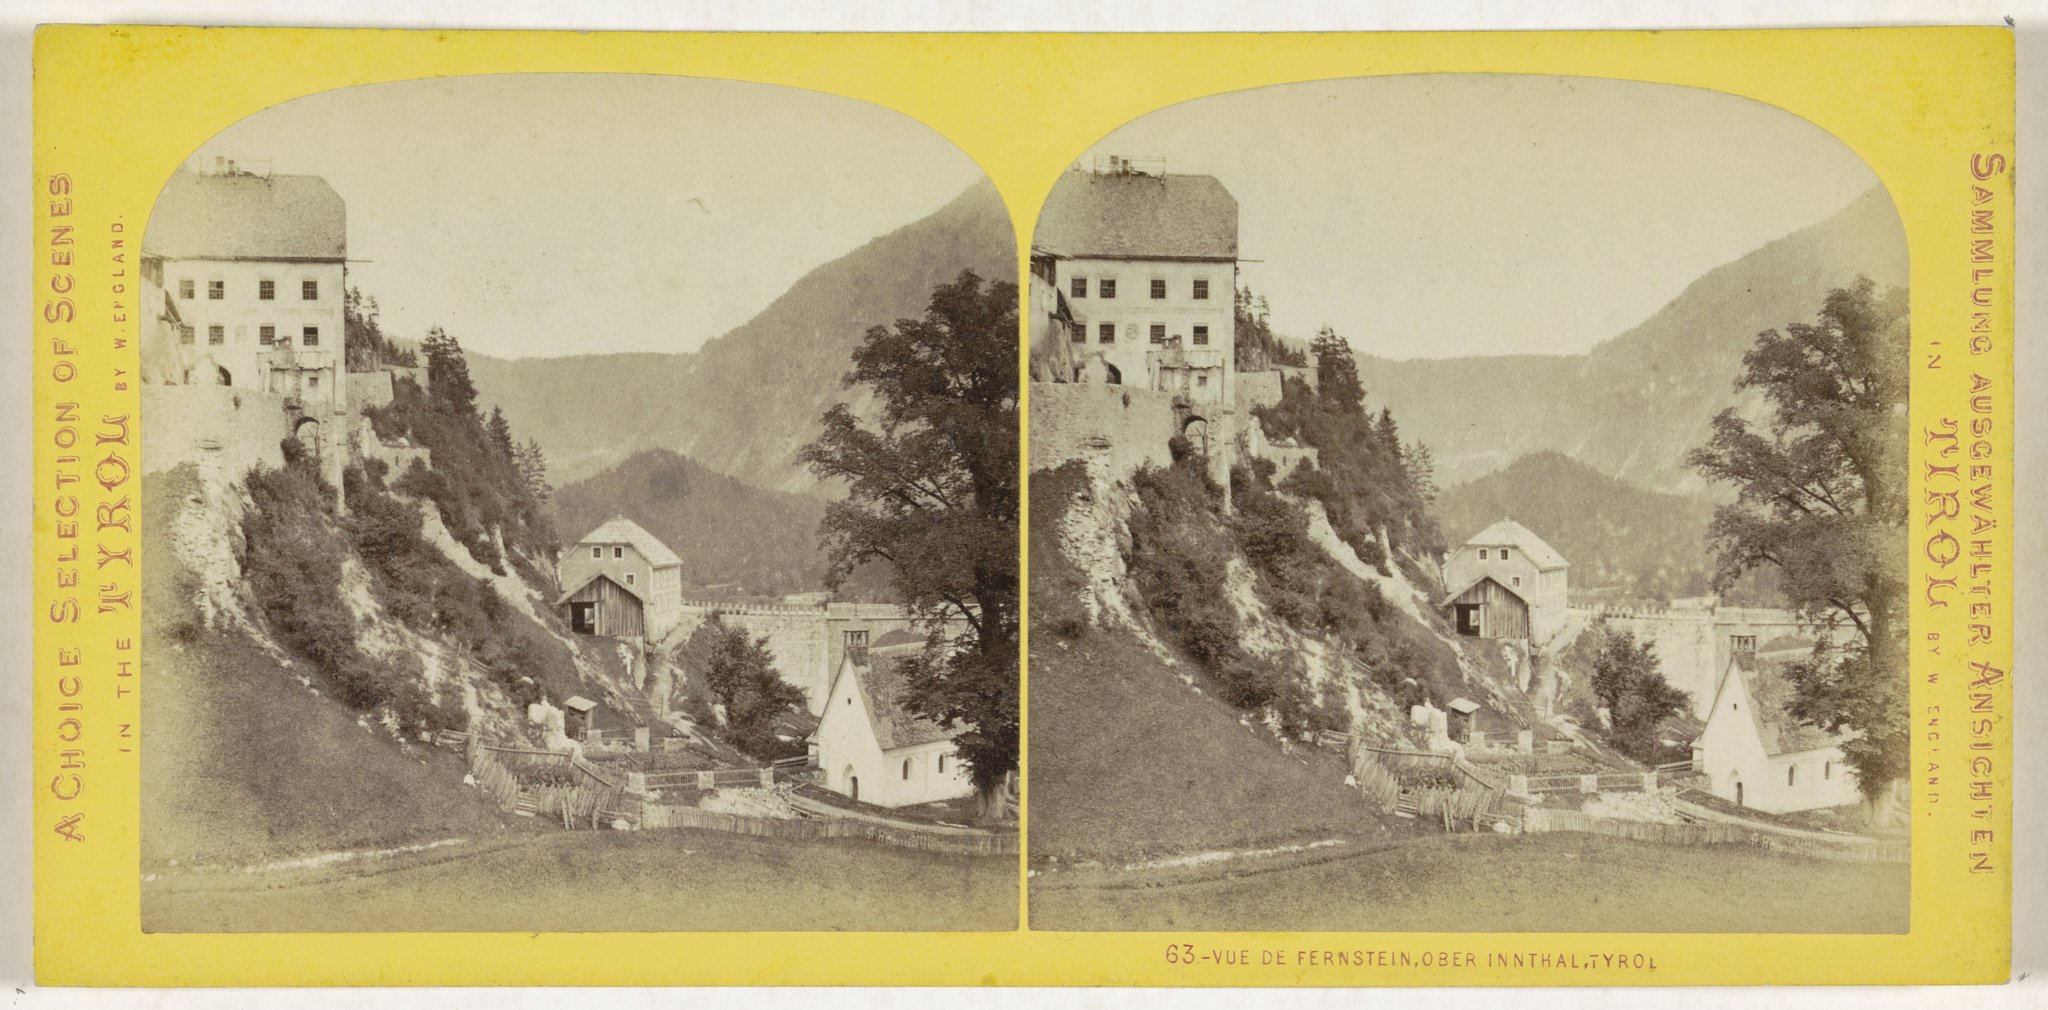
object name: stereograph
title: Gezicht vanaf Brug Fernstein richting het dal, Tirol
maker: william england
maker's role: fotograaf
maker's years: 1816-1896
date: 1863-1865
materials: cardboard, paper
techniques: albumen print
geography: burg fernstein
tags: landscape with tower or castle, mountains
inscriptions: number: ‘63’